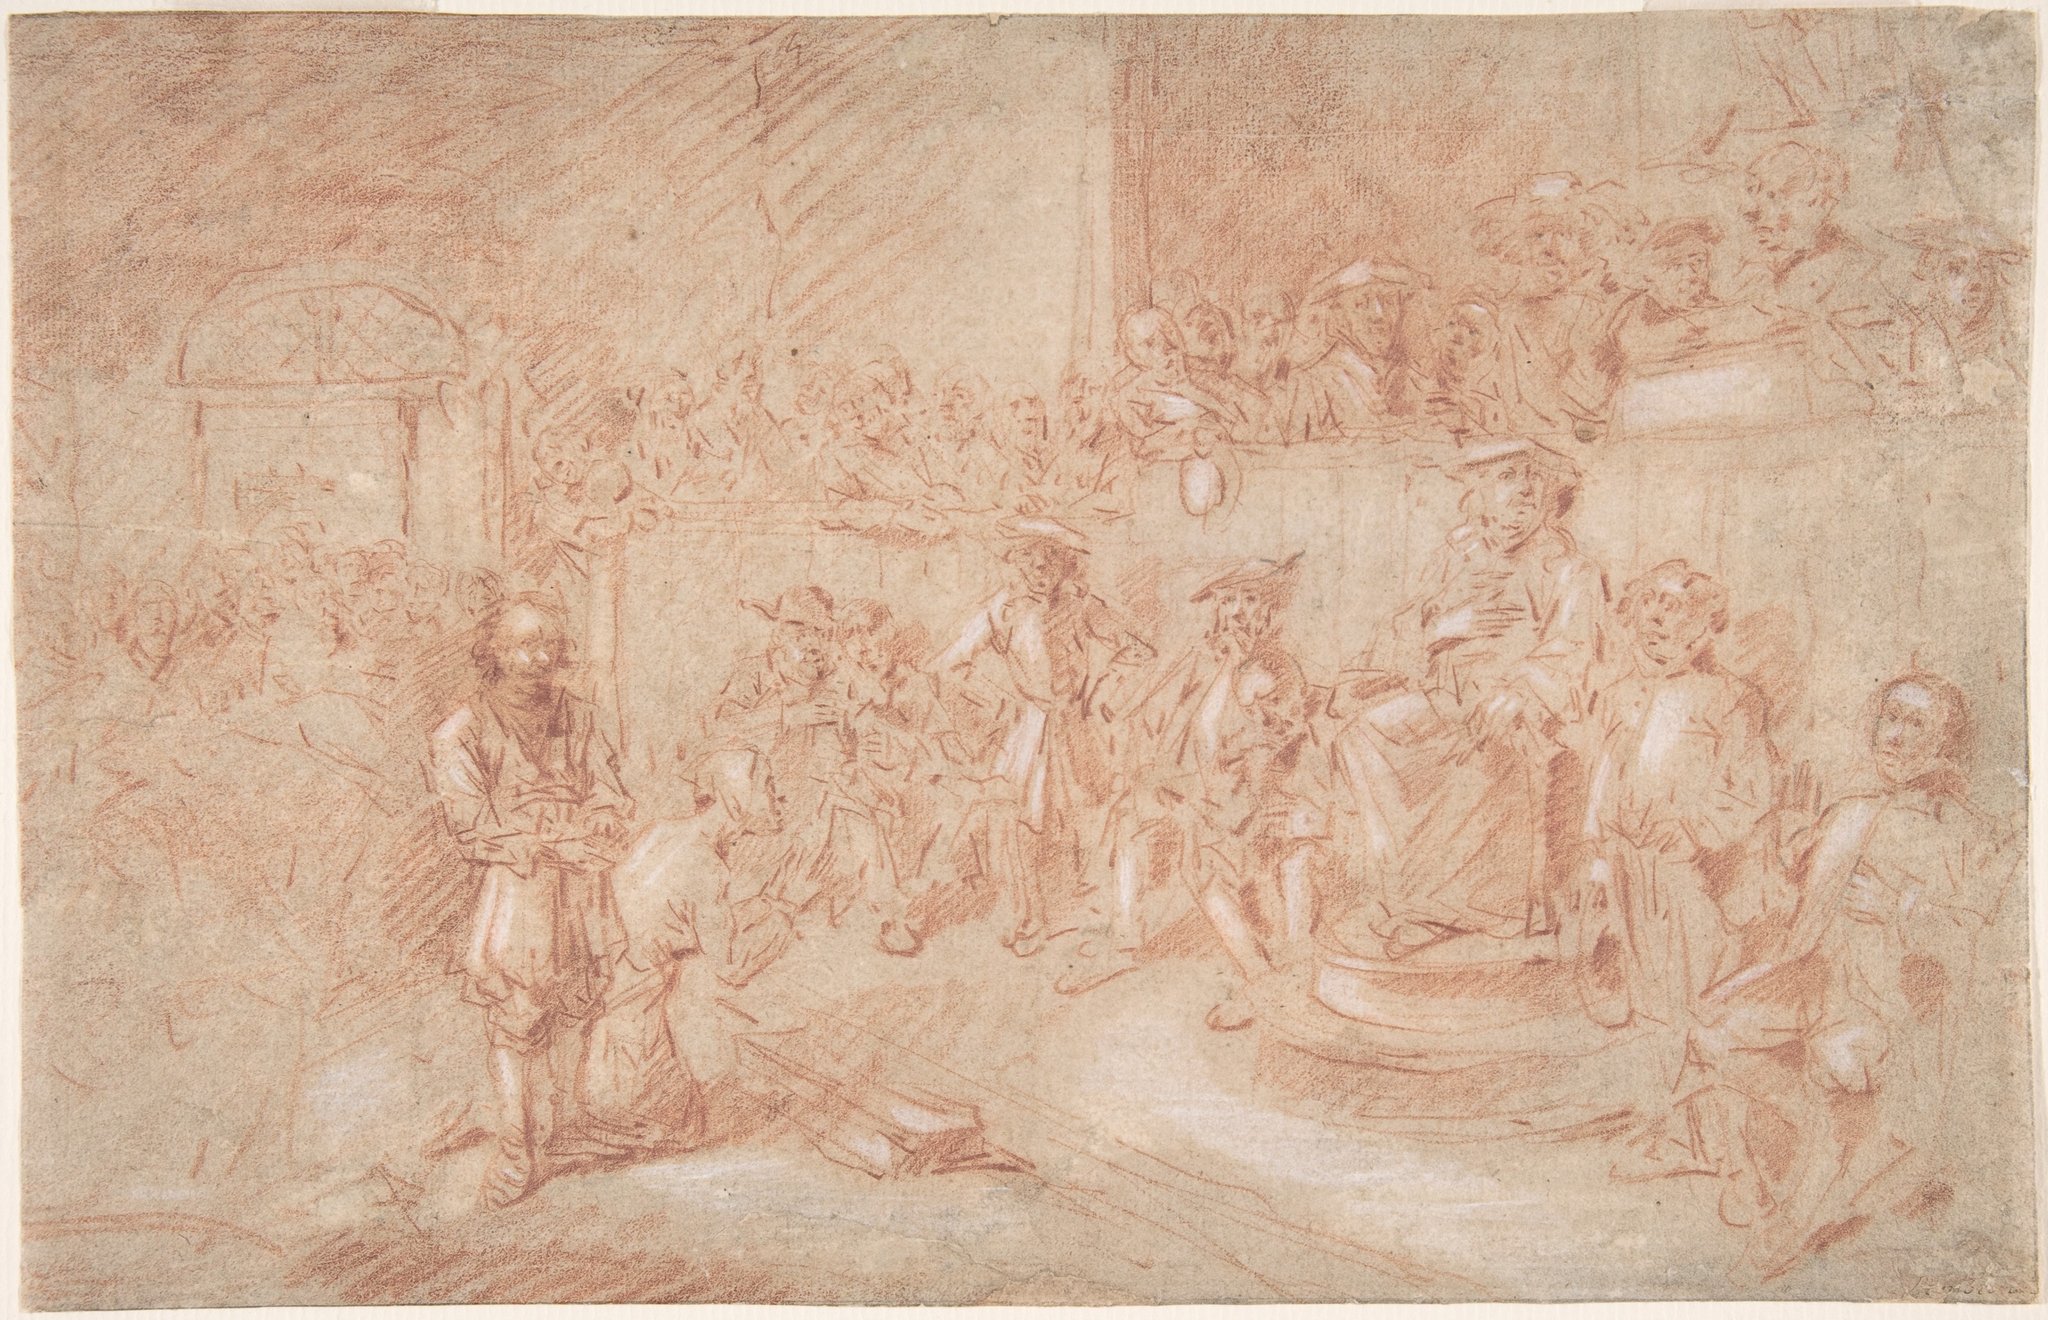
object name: drawing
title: Two Men Before a Judge in a Crowded Courtroom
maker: egbert jasperszoon van heemskerck i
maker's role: artist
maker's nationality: dutch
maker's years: 1634-1705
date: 1667-1700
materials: chalk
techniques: heightening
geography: netherlands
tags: men,crowd